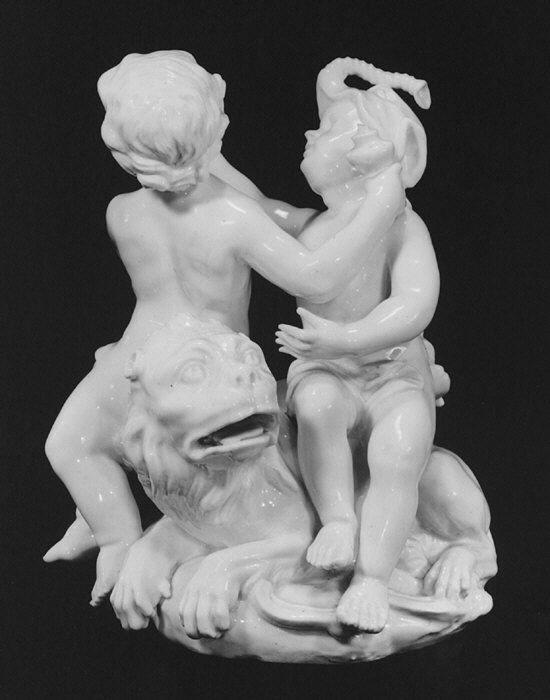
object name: group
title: Asia and Africa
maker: friedrich elias meyer (i)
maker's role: sculptor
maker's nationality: german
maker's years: 1723-1785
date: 1750-1760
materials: soft paste porcelain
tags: children,lions